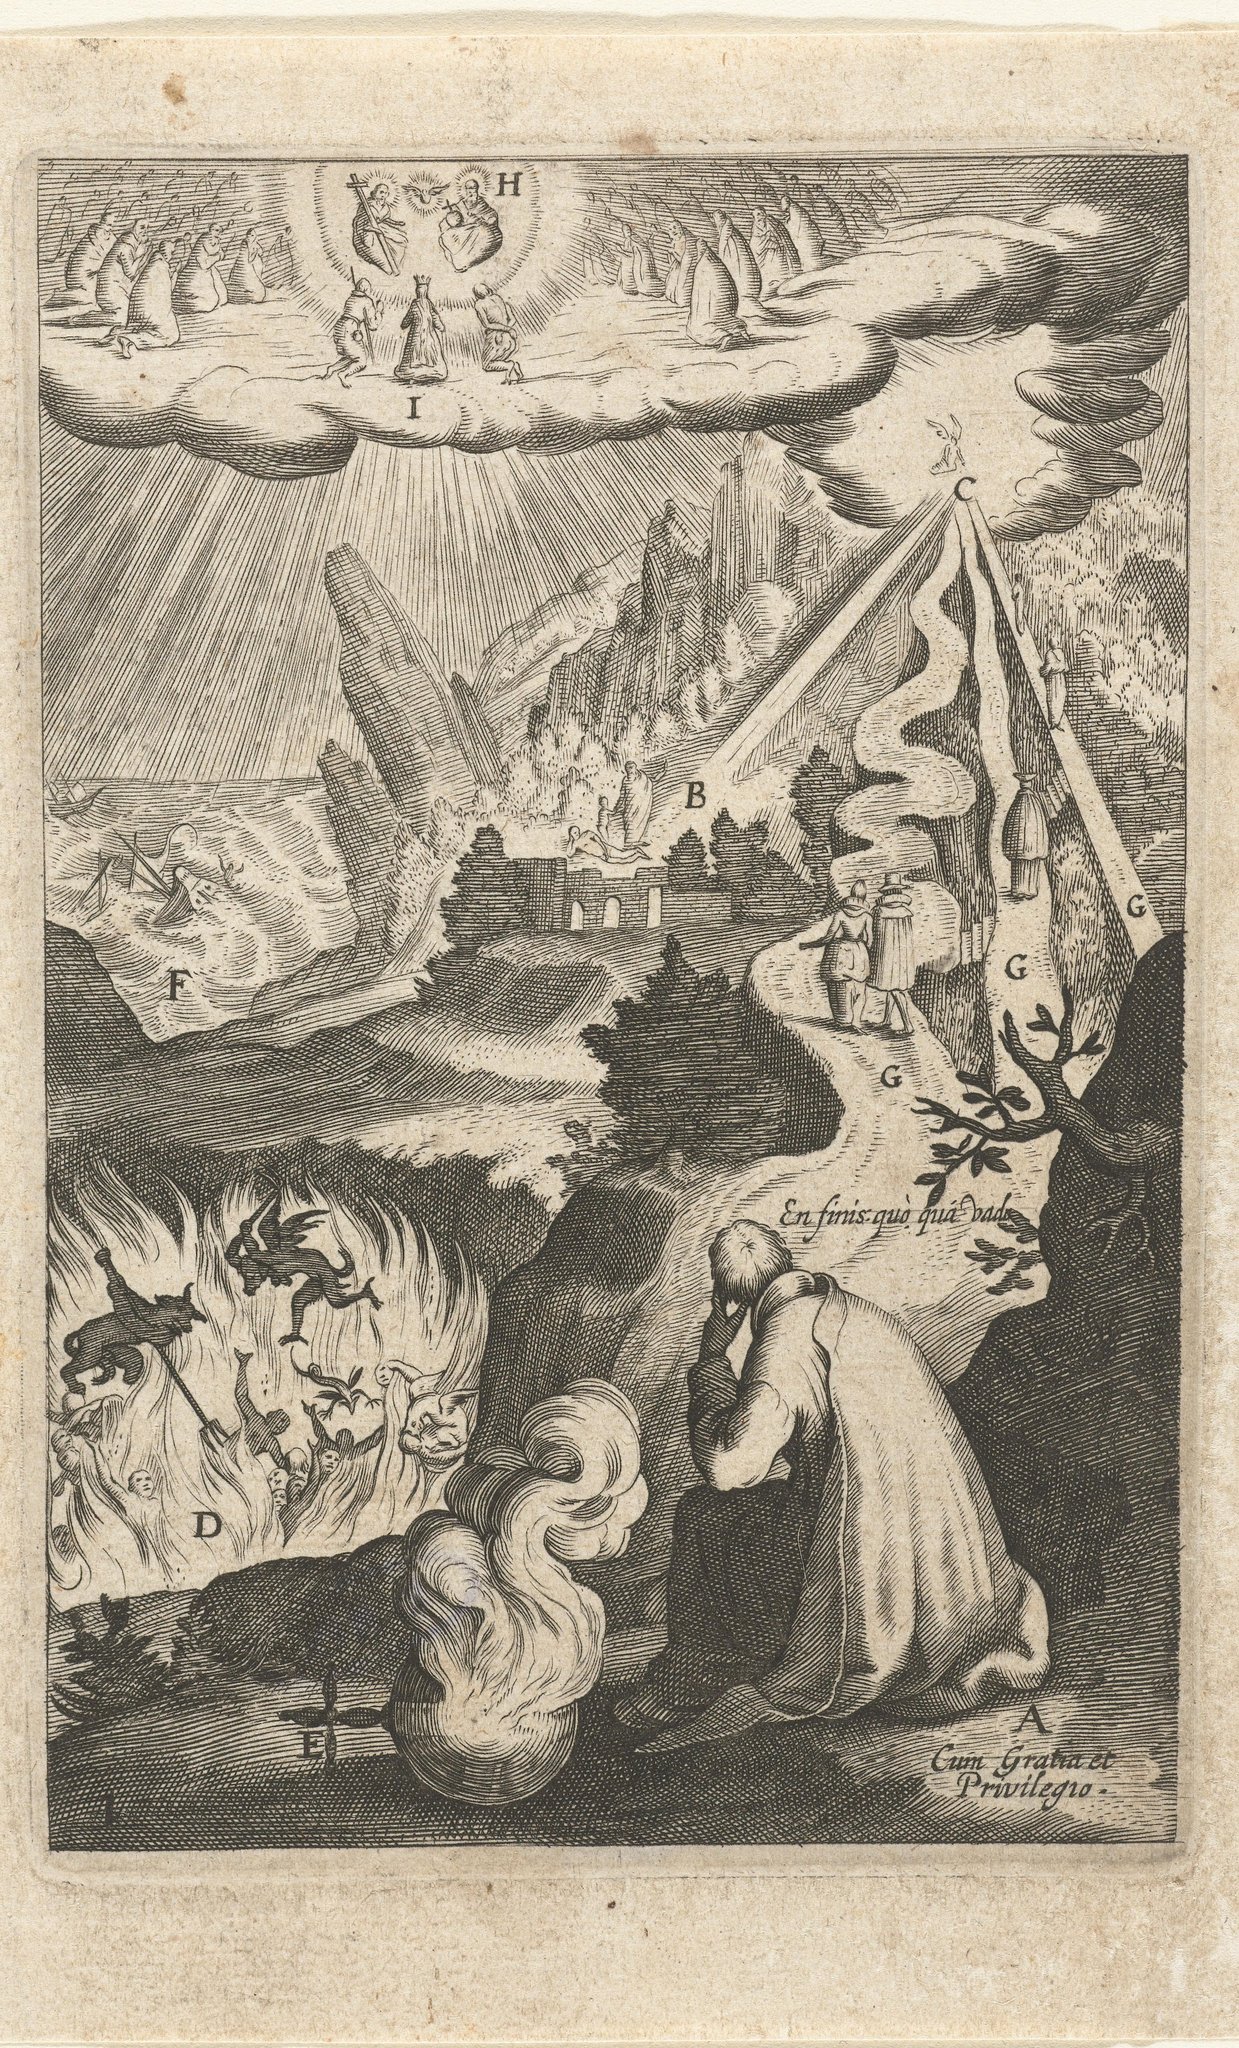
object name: book illustration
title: Embleem met man die overweegt welke weg hij in het leven gaat bewandelen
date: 1620-1623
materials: paper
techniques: engraving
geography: antwerp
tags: the life of man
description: Prent uit: Antoine Sucquet, Den wech des eeuwich levens, beschreven int latijn : met beelden verlicht door Boëtius a Bolsvert, Antwerpen, Hendrick Aertssens, 1623